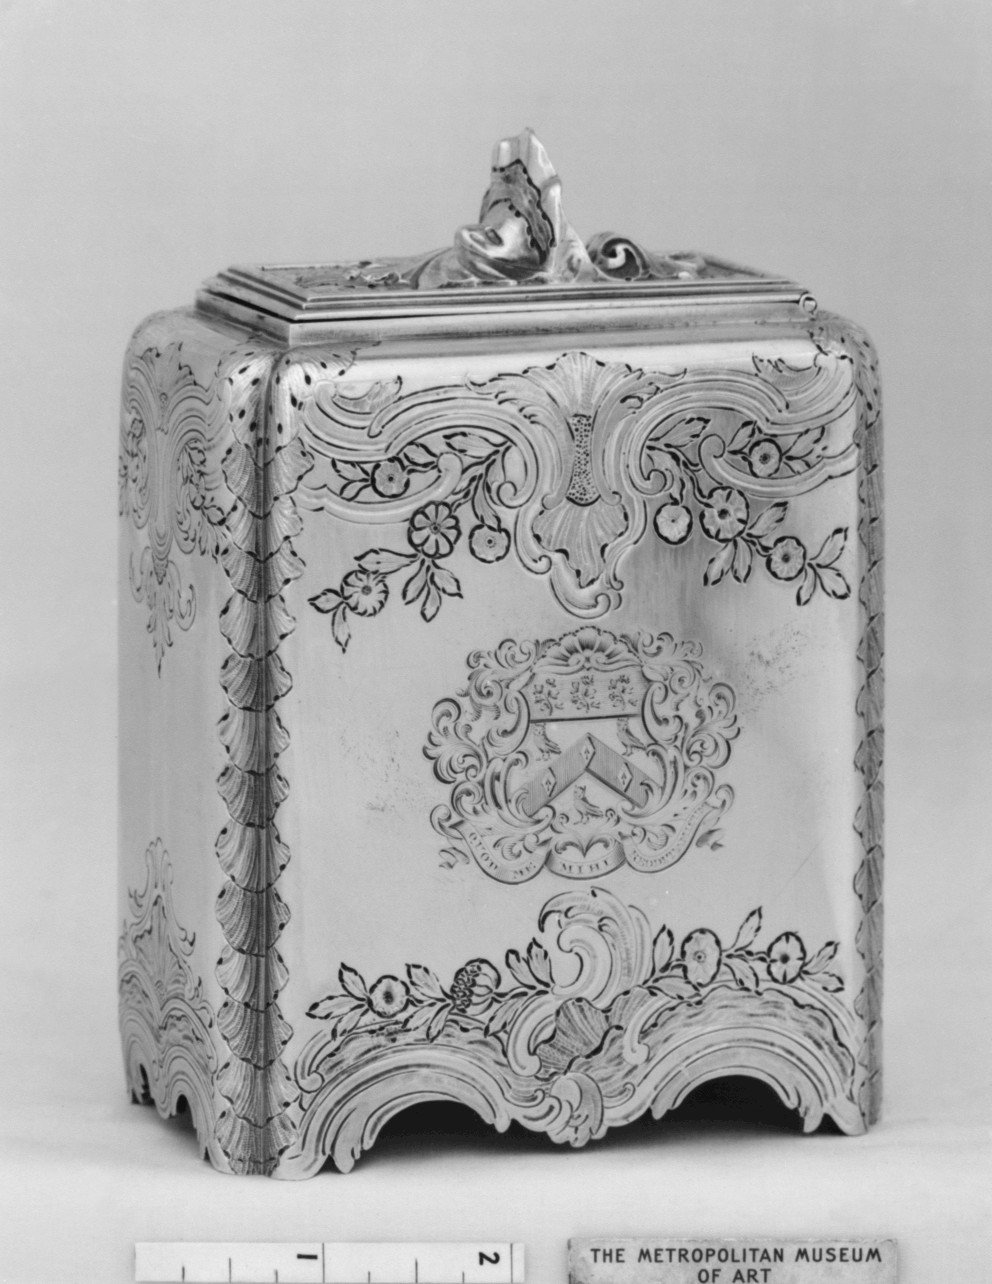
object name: tea caddy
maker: paul de lamerie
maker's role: maker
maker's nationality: british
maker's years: 1688-1751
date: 1745-1746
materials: silver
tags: coat of arms